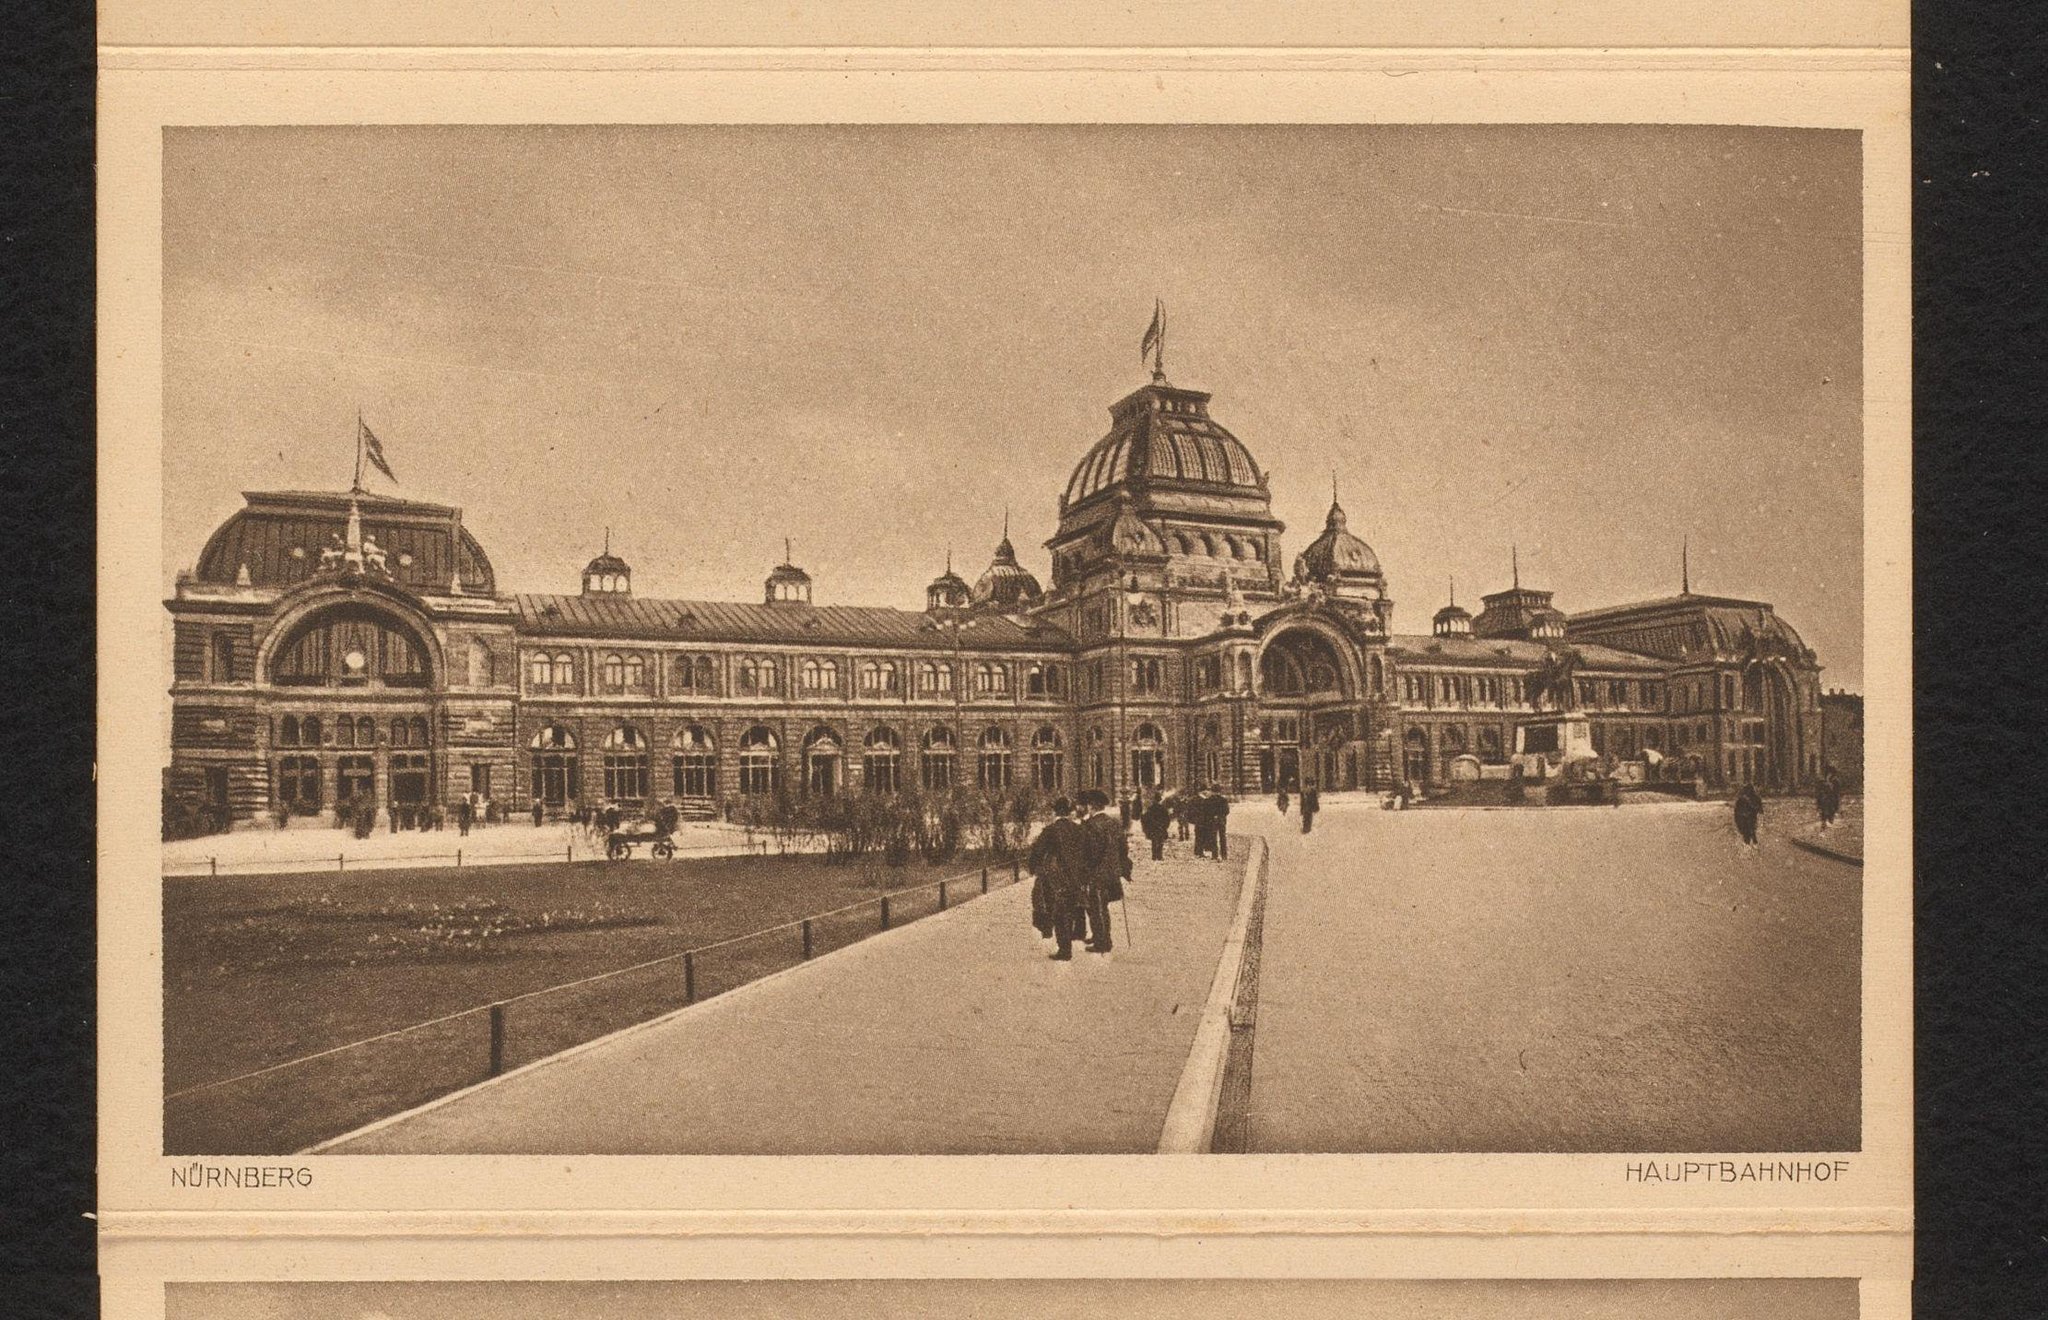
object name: photomechanical print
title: Nürnberg. Hauptbahnhof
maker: Anonymous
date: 1905-1930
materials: cardboard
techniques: rotogravure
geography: nuremberg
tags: station; shelter (railway, tramway)